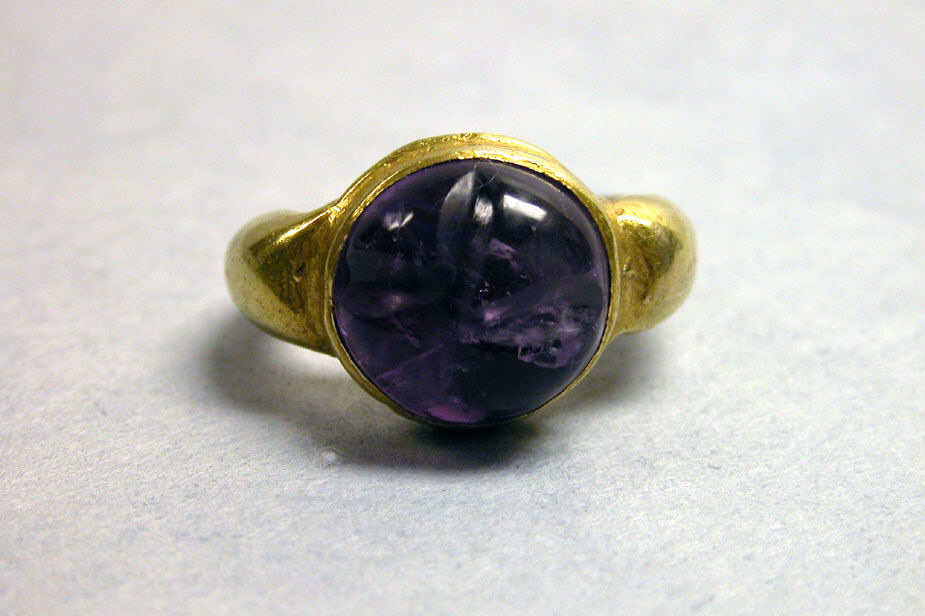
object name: ring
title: Stirrup-shaped Ring with Large Circular Stone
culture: indonesian, javanese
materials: gold, stone